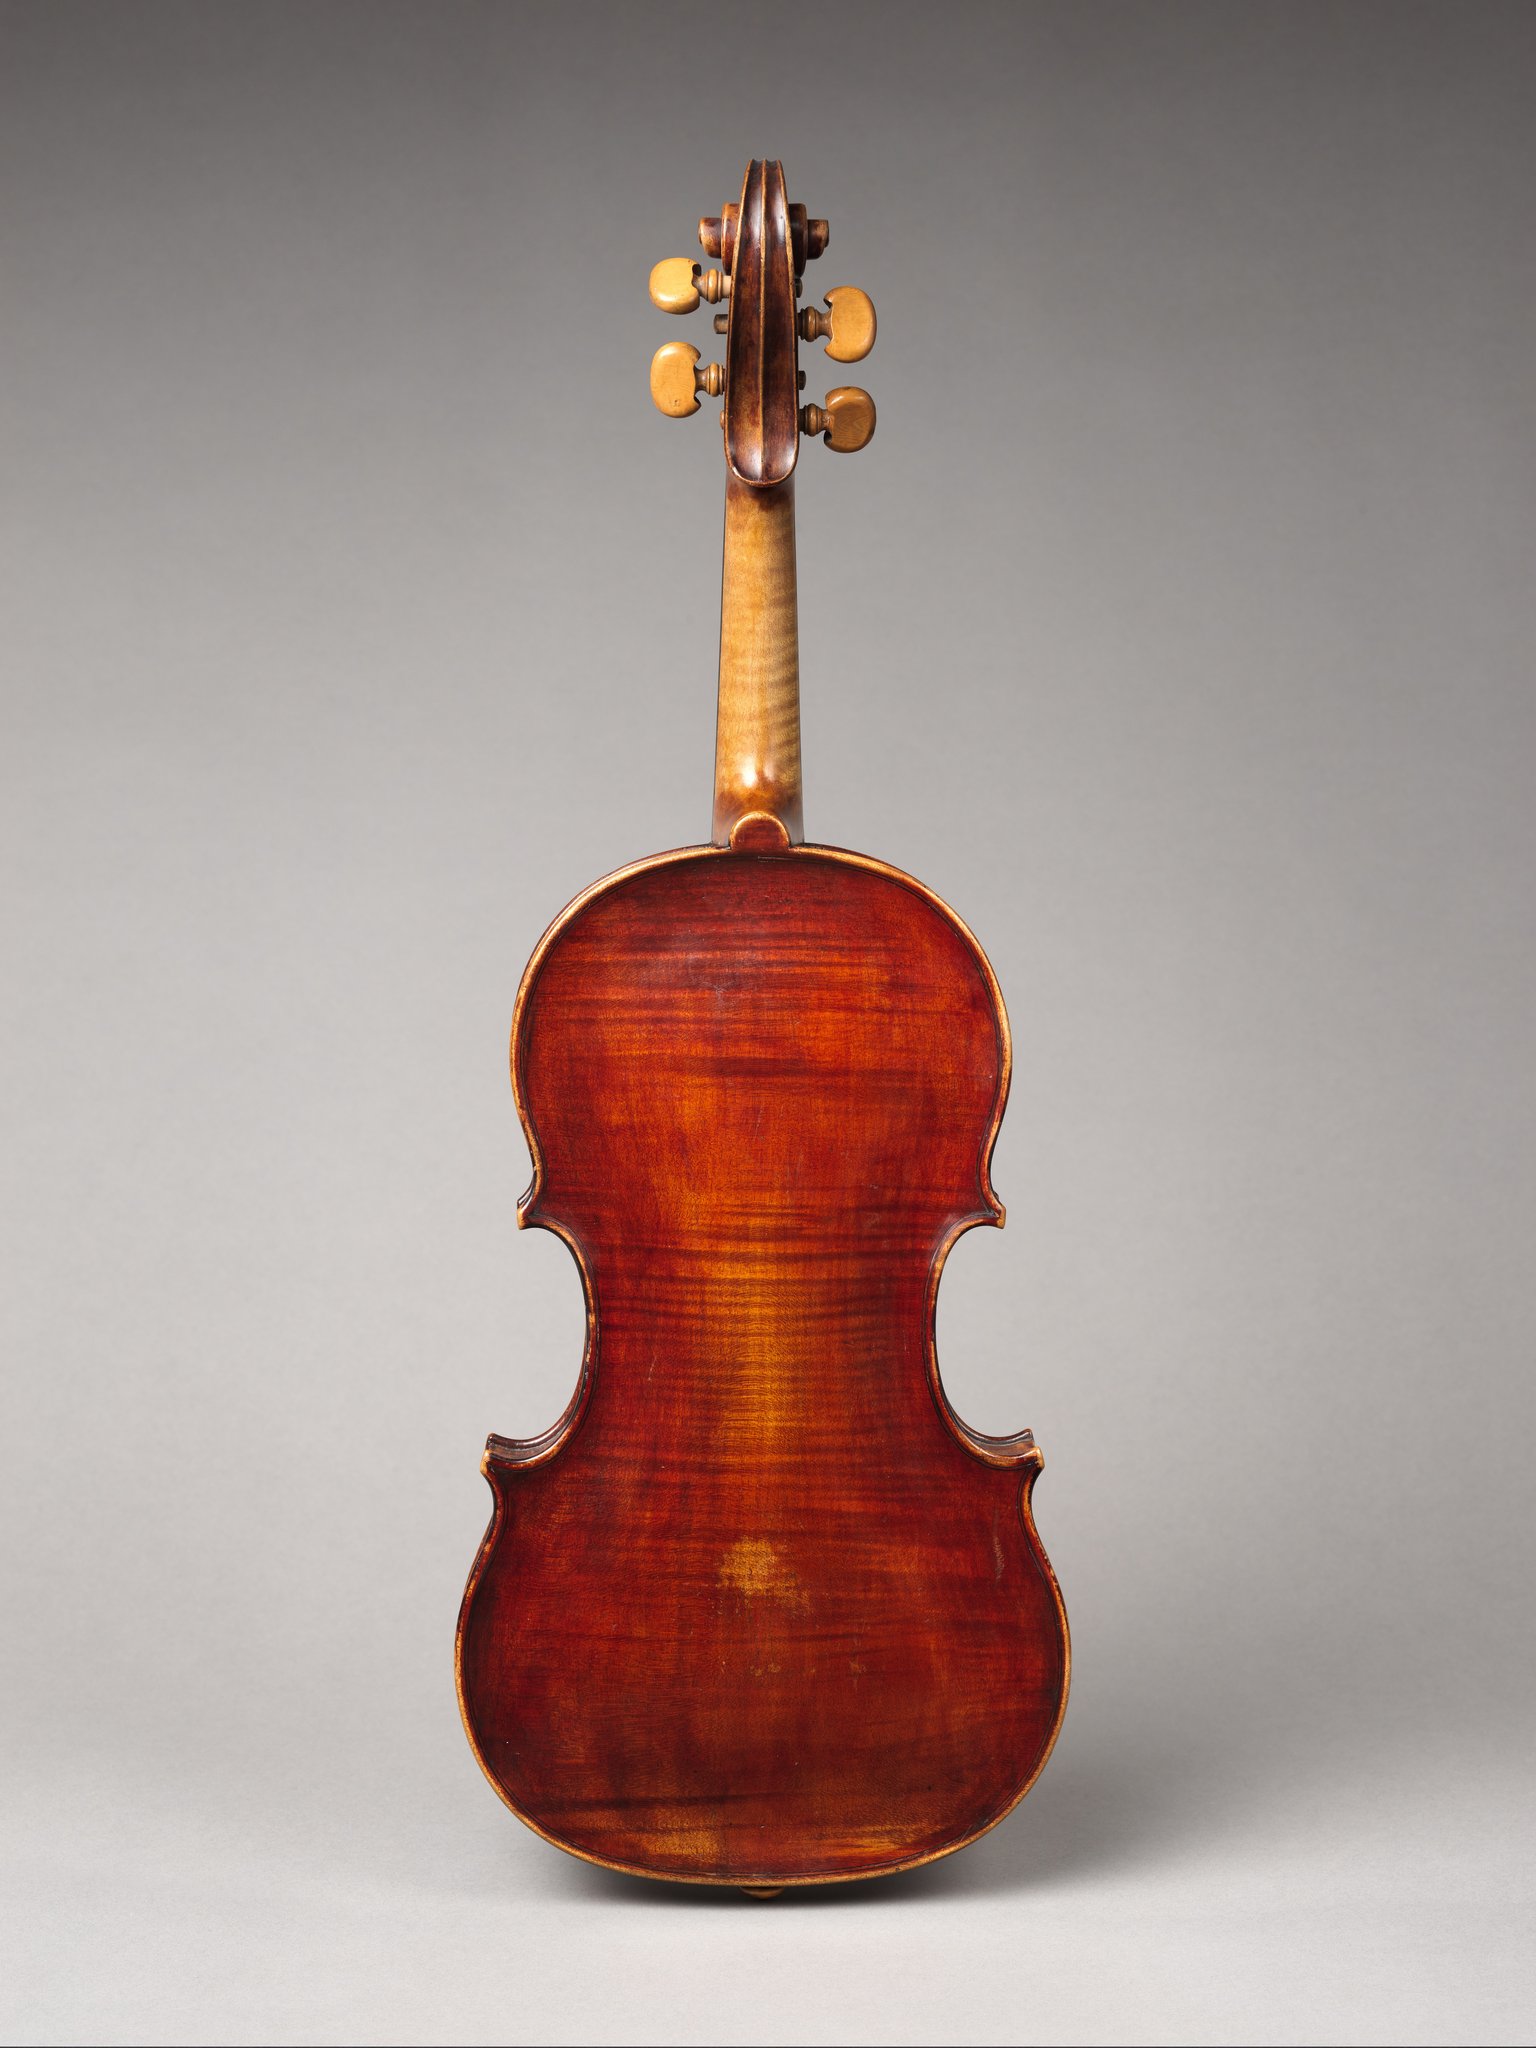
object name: viola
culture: british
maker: benjamin banks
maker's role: maker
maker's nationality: british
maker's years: 1727-1795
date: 1791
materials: wood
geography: united kingdom